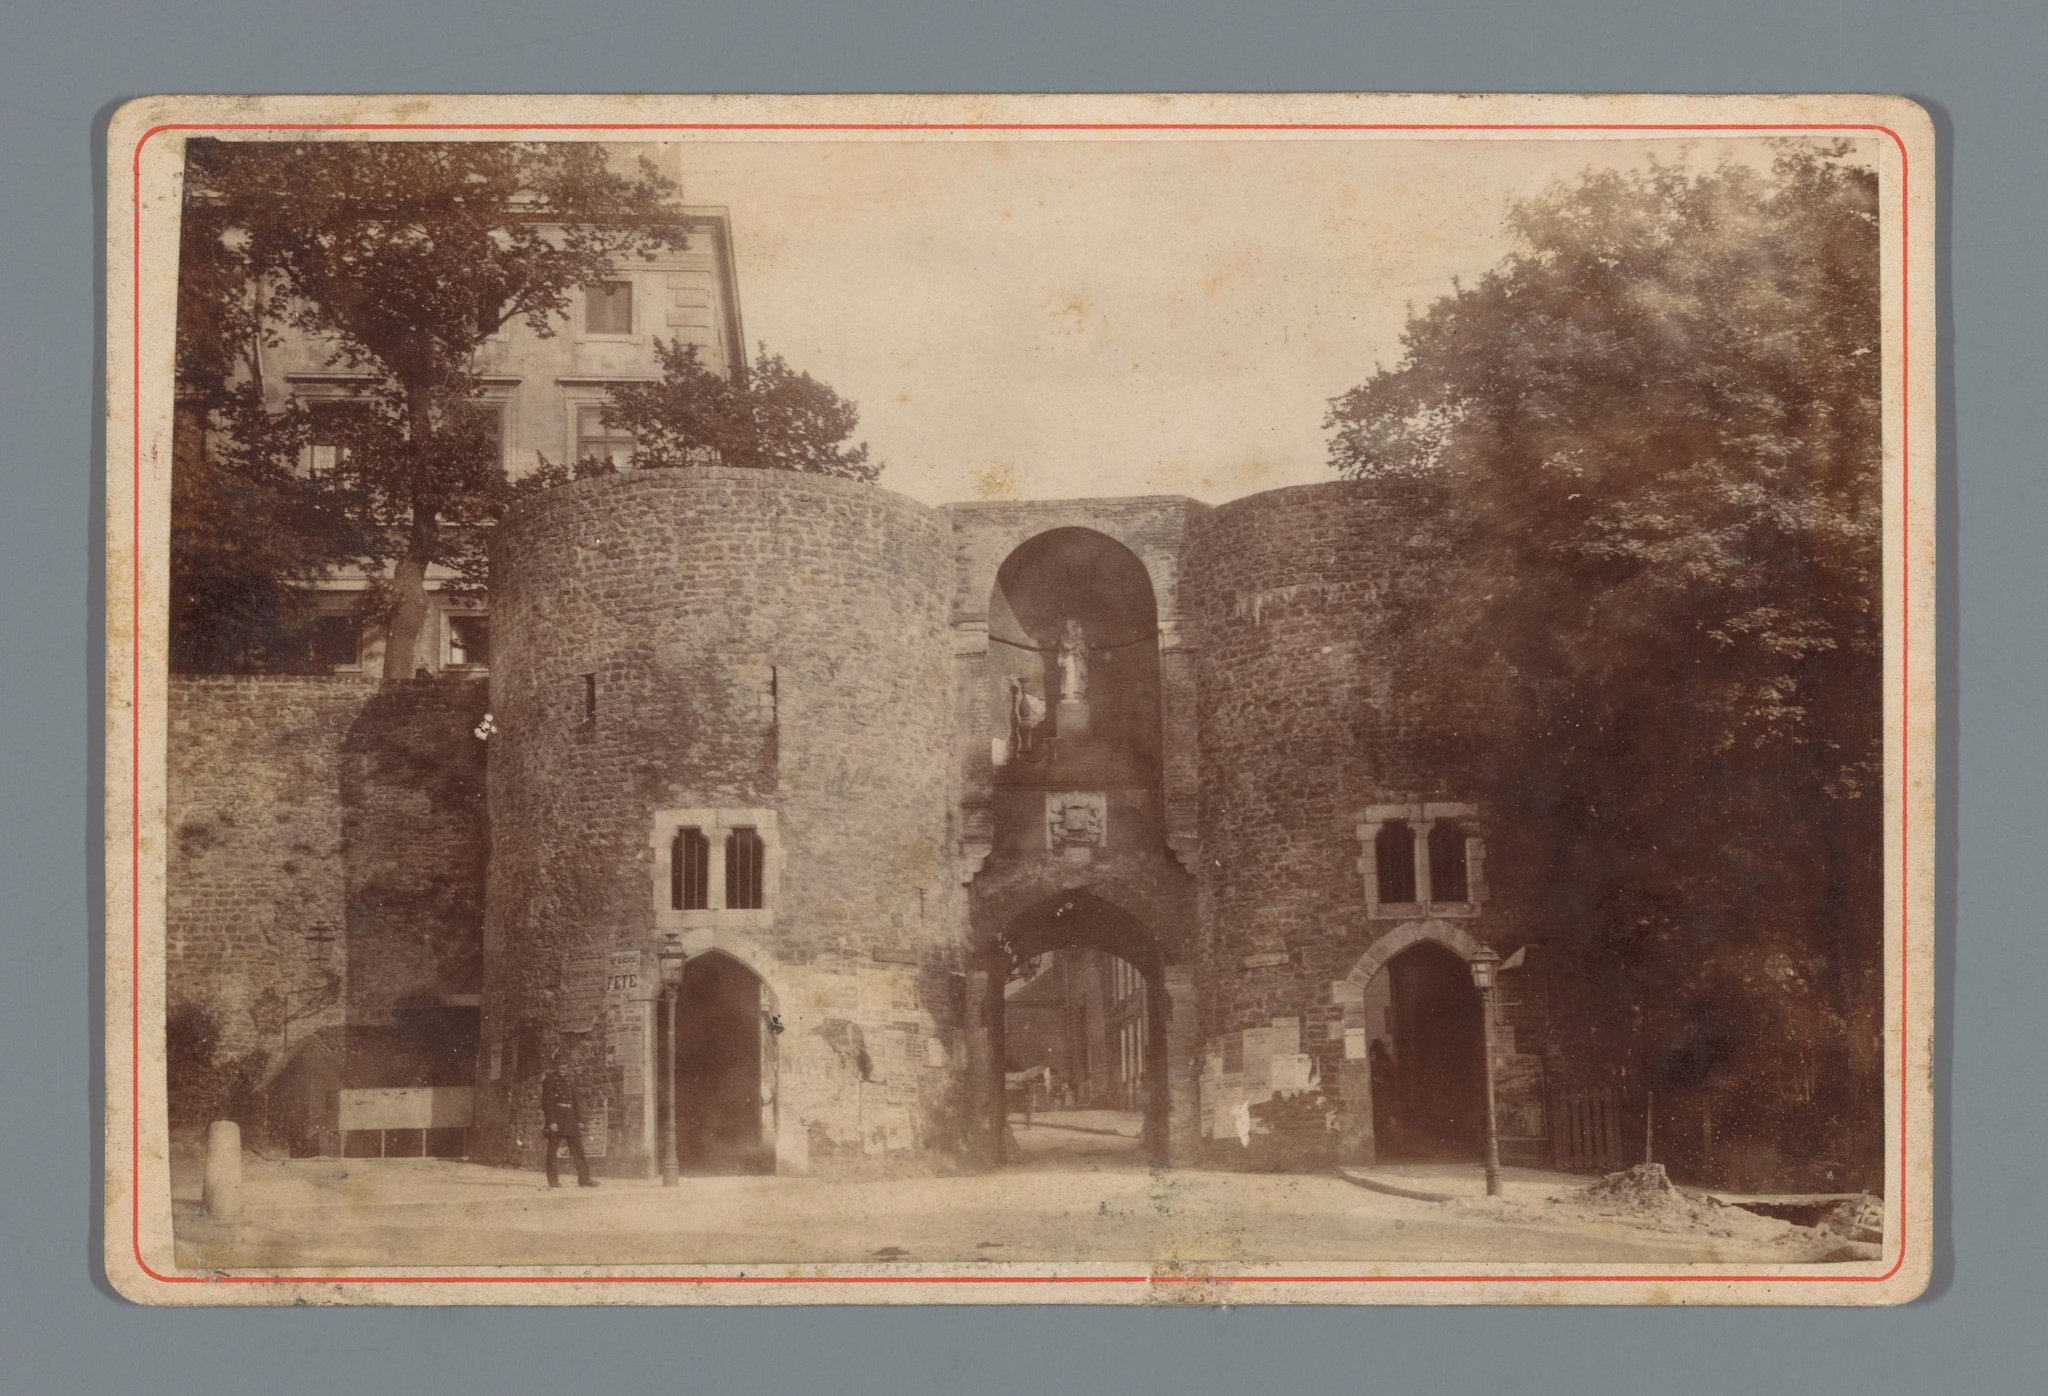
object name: cabinet photograph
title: Gezicht op de Porte des Dunes te Boulogne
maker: Anonymous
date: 1895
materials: cardboard, photographic support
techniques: albumen print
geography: boulogne-sur-mer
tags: gate, entrance, façade (of house or building)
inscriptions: date: ‘15 Septembre 1895’, annotation: ‘Boulogne, Porte des Dunes’